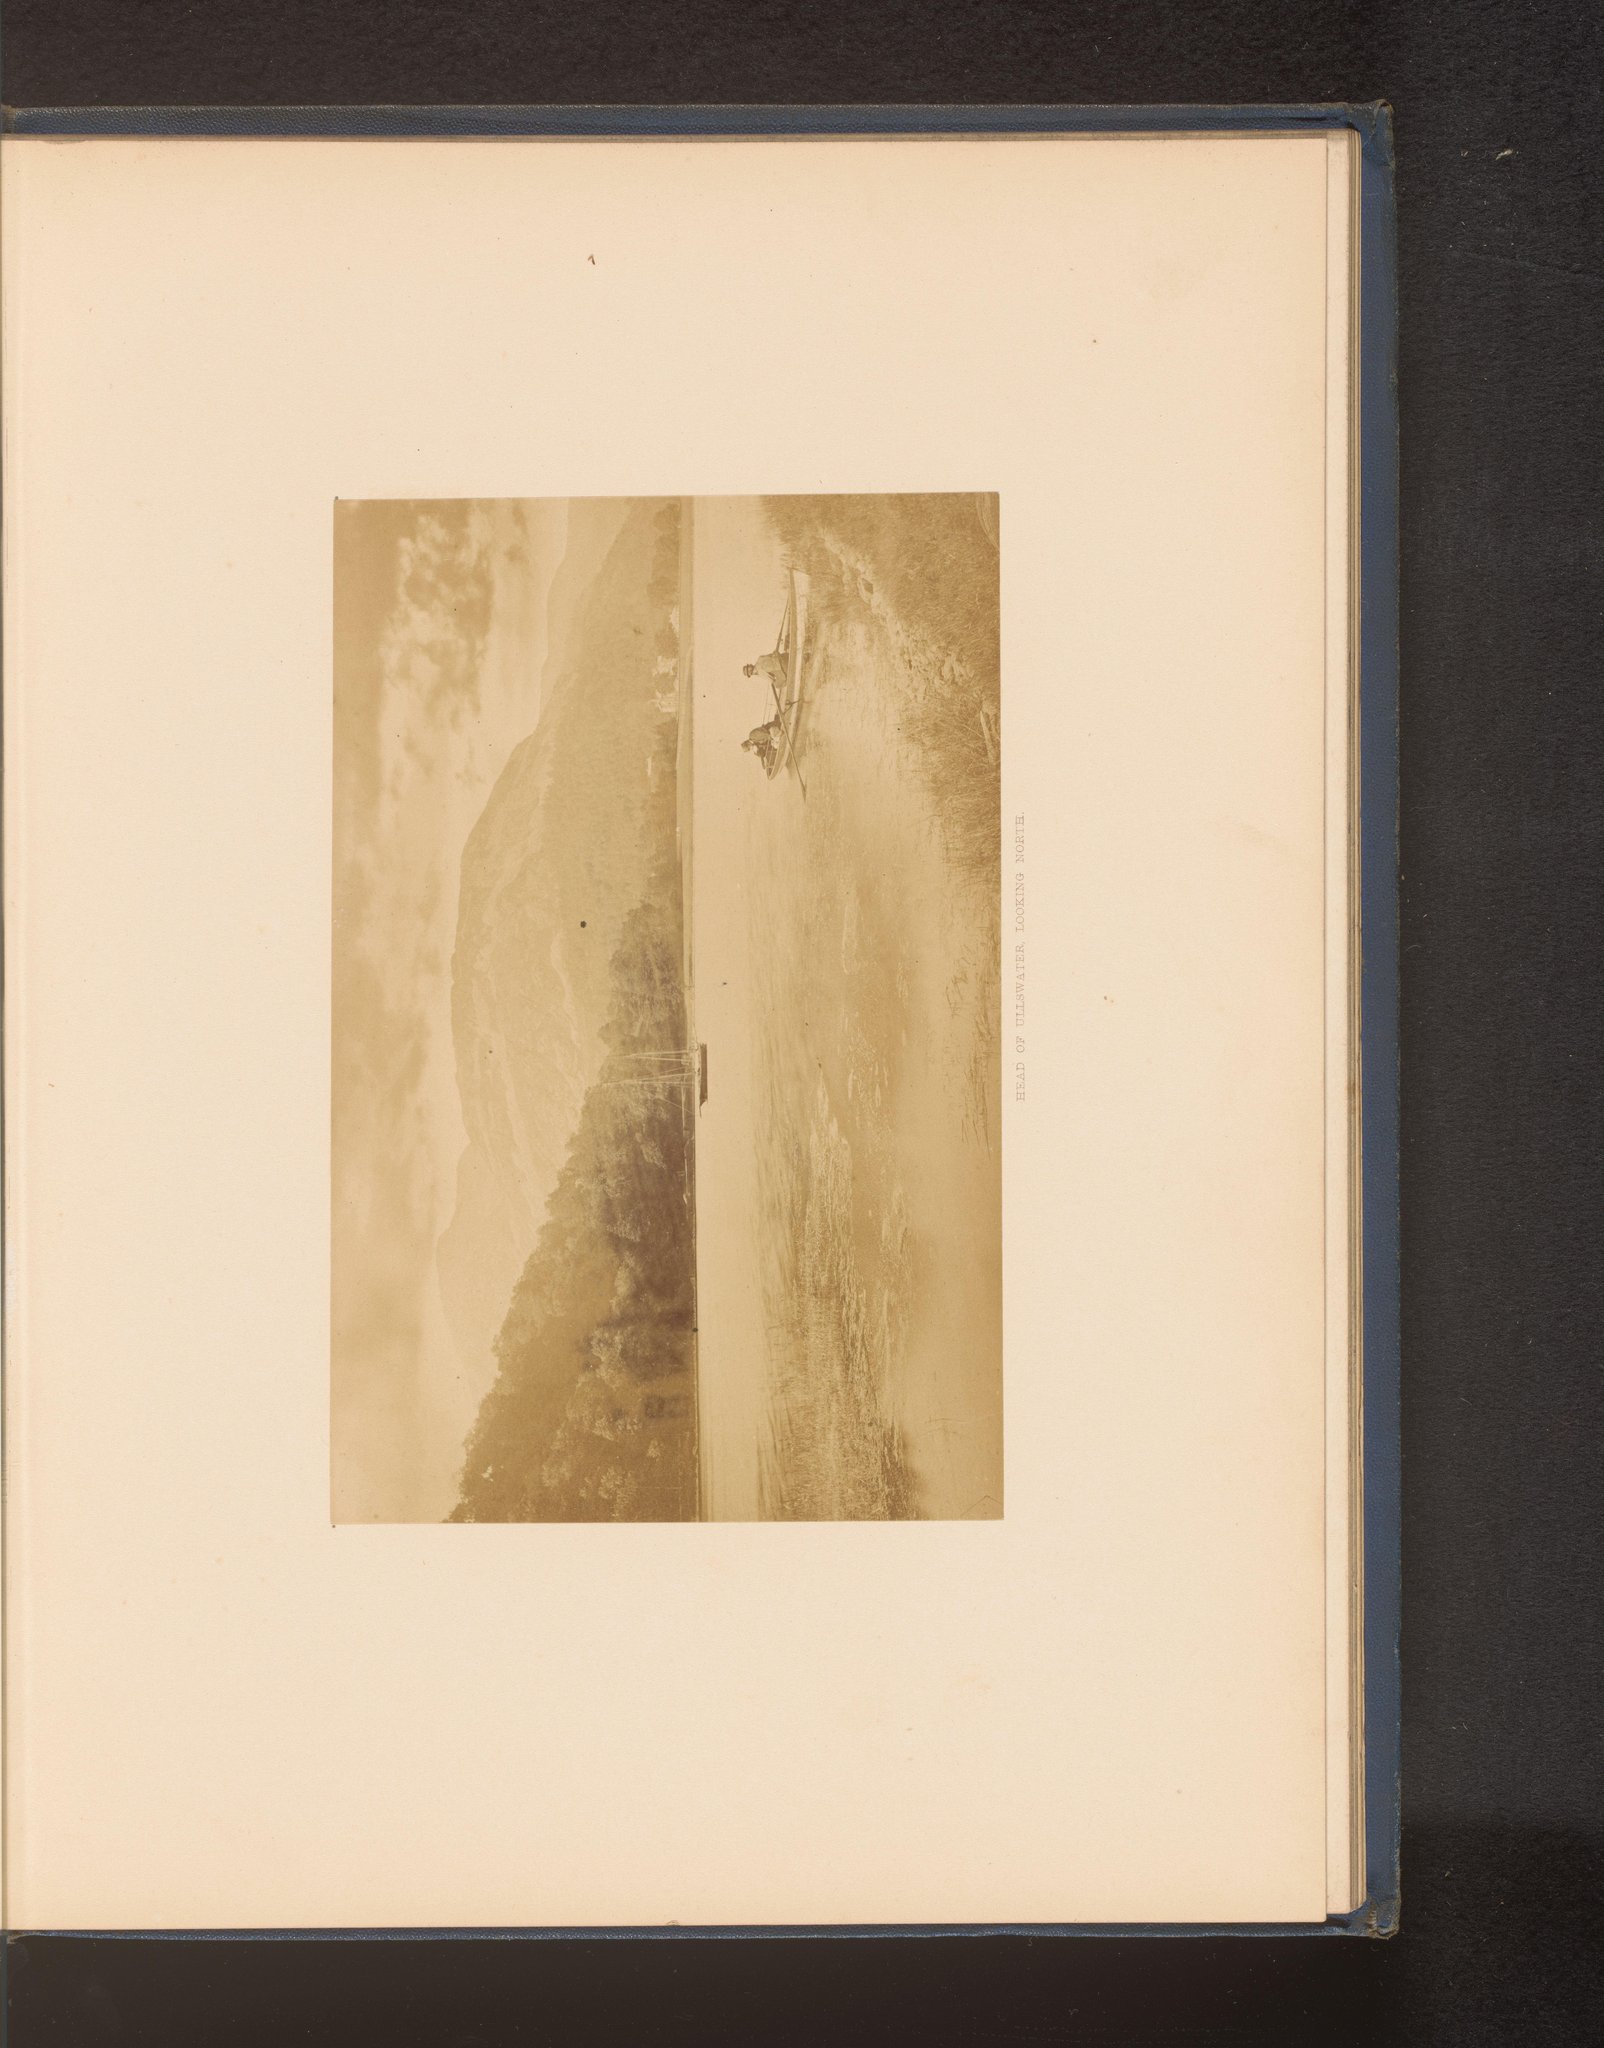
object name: page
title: Head of Ullswater, looking north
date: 1857-1867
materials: photographic support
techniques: albumen print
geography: lake district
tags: sailing-ship, sailing-boat, rowing-boat, canoe, etc., lake, mountains